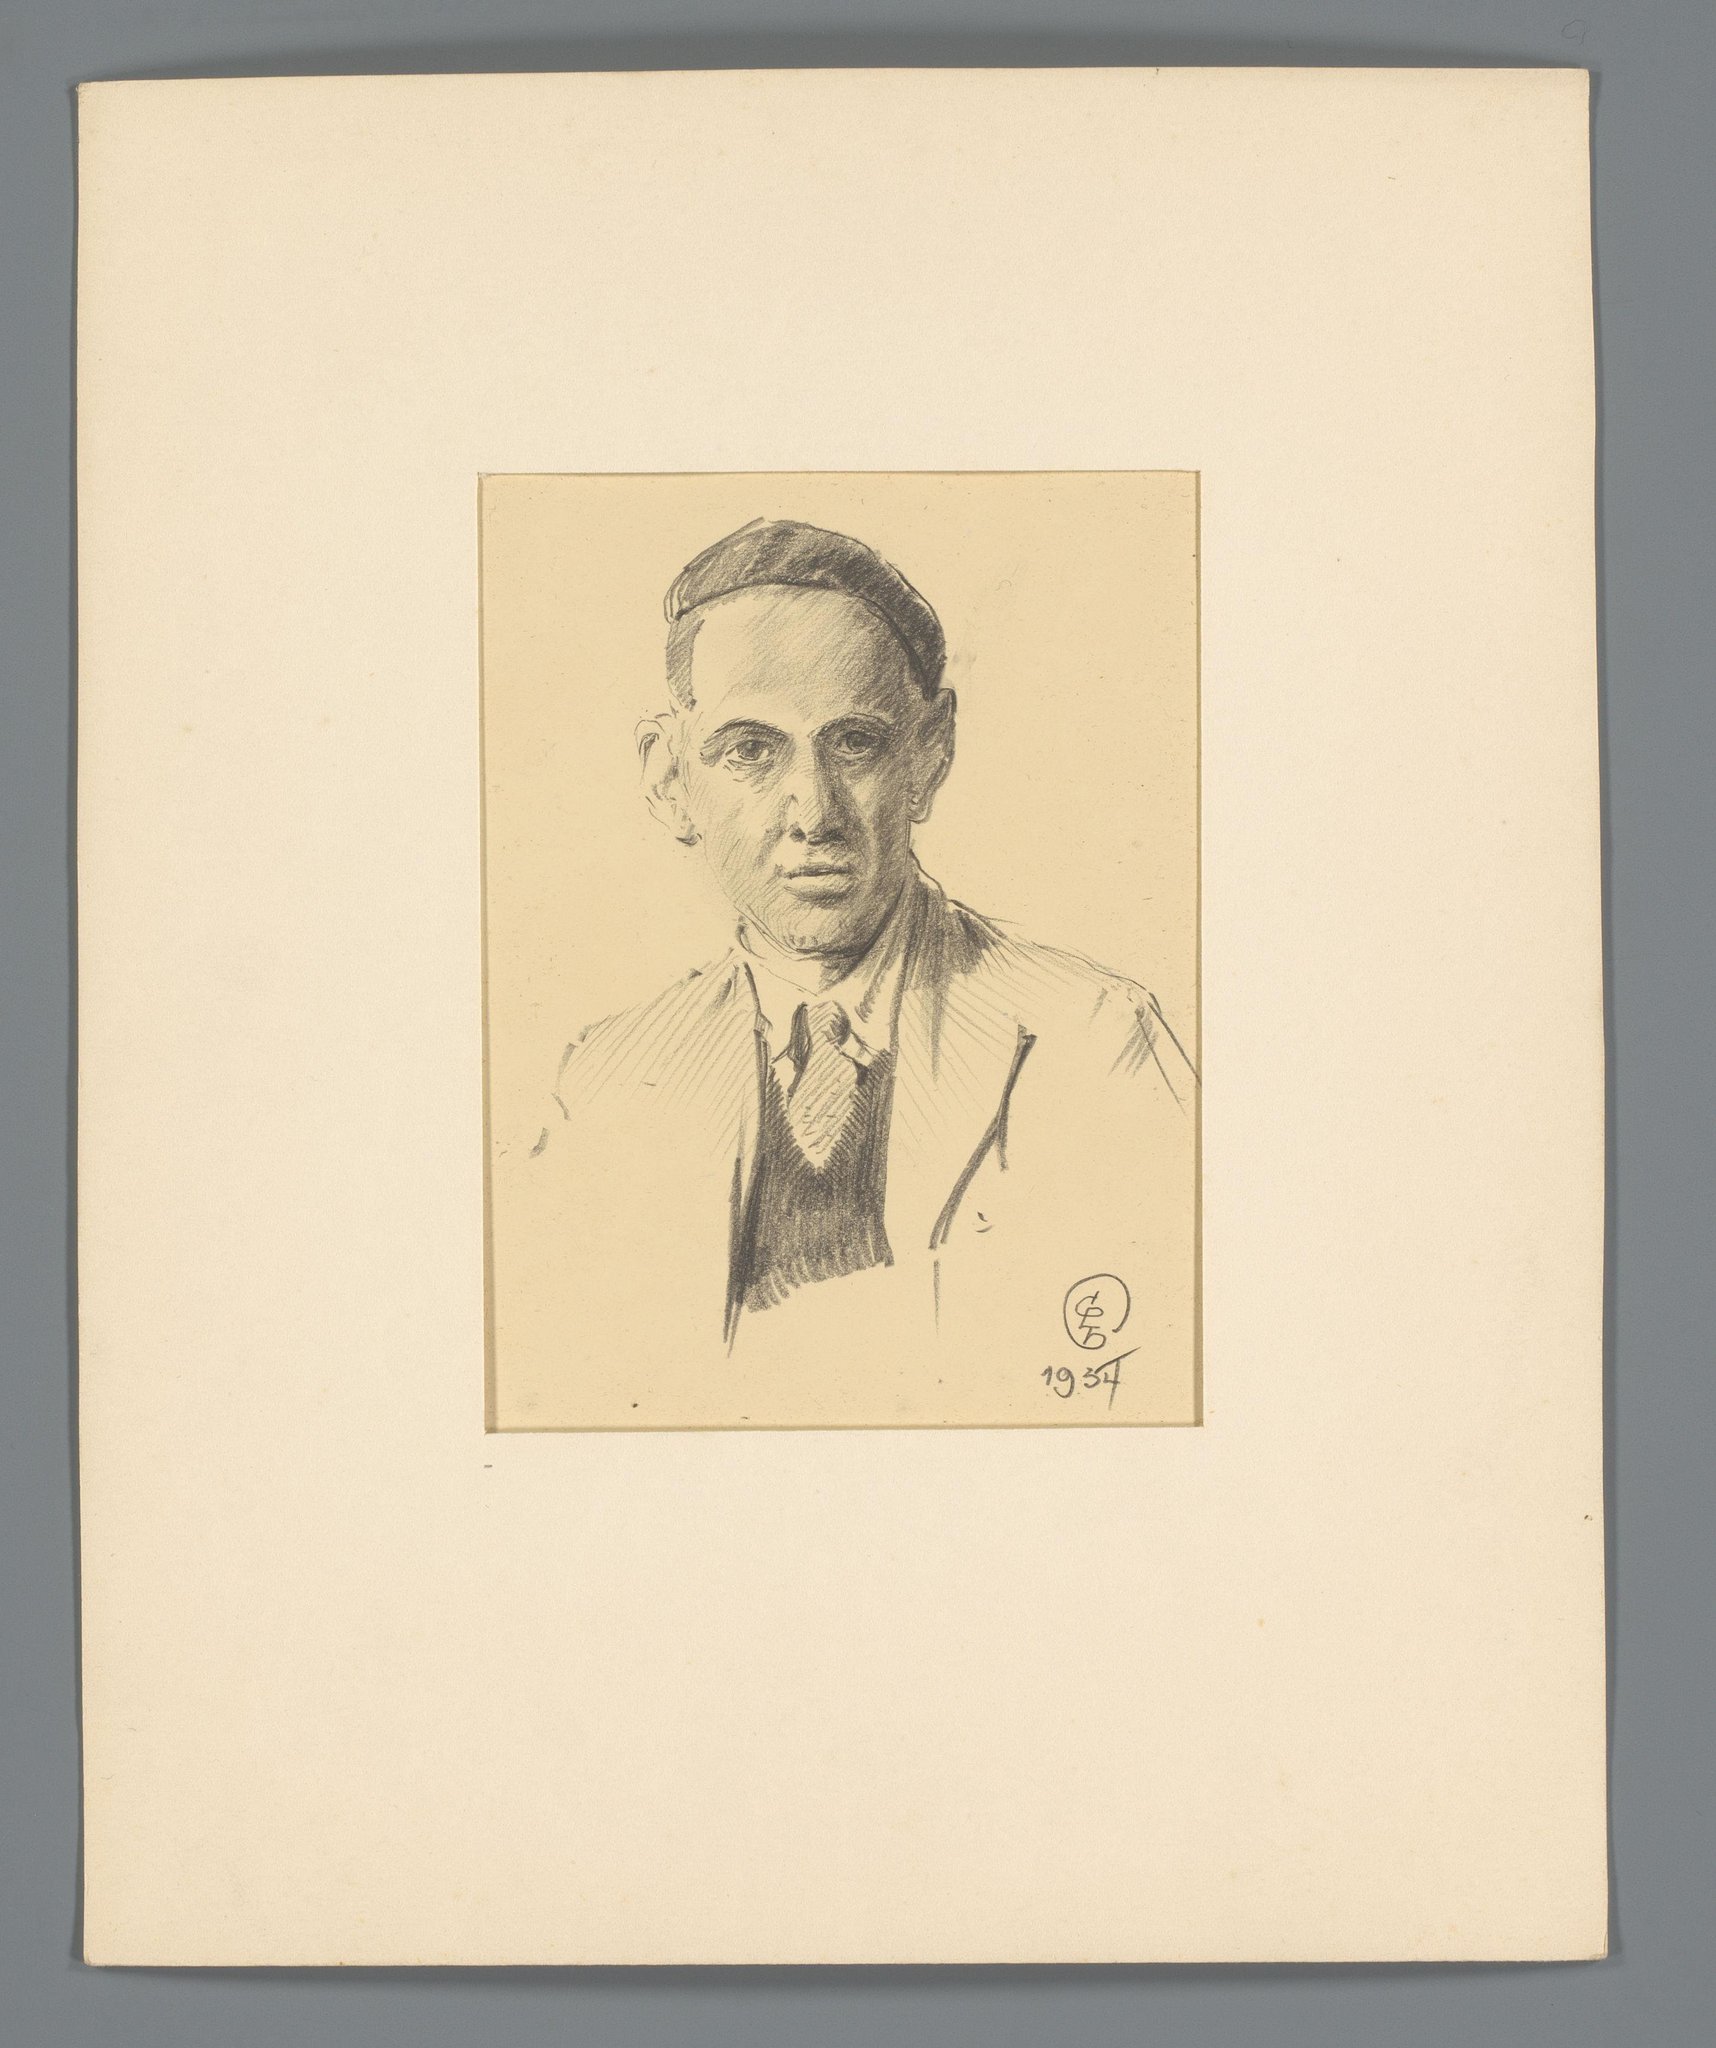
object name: drawing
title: Portret van een man, mogelijk C.F. van Schagen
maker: Anonymous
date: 1934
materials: chalk, paper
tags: historical persons not known by name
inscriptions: monogram